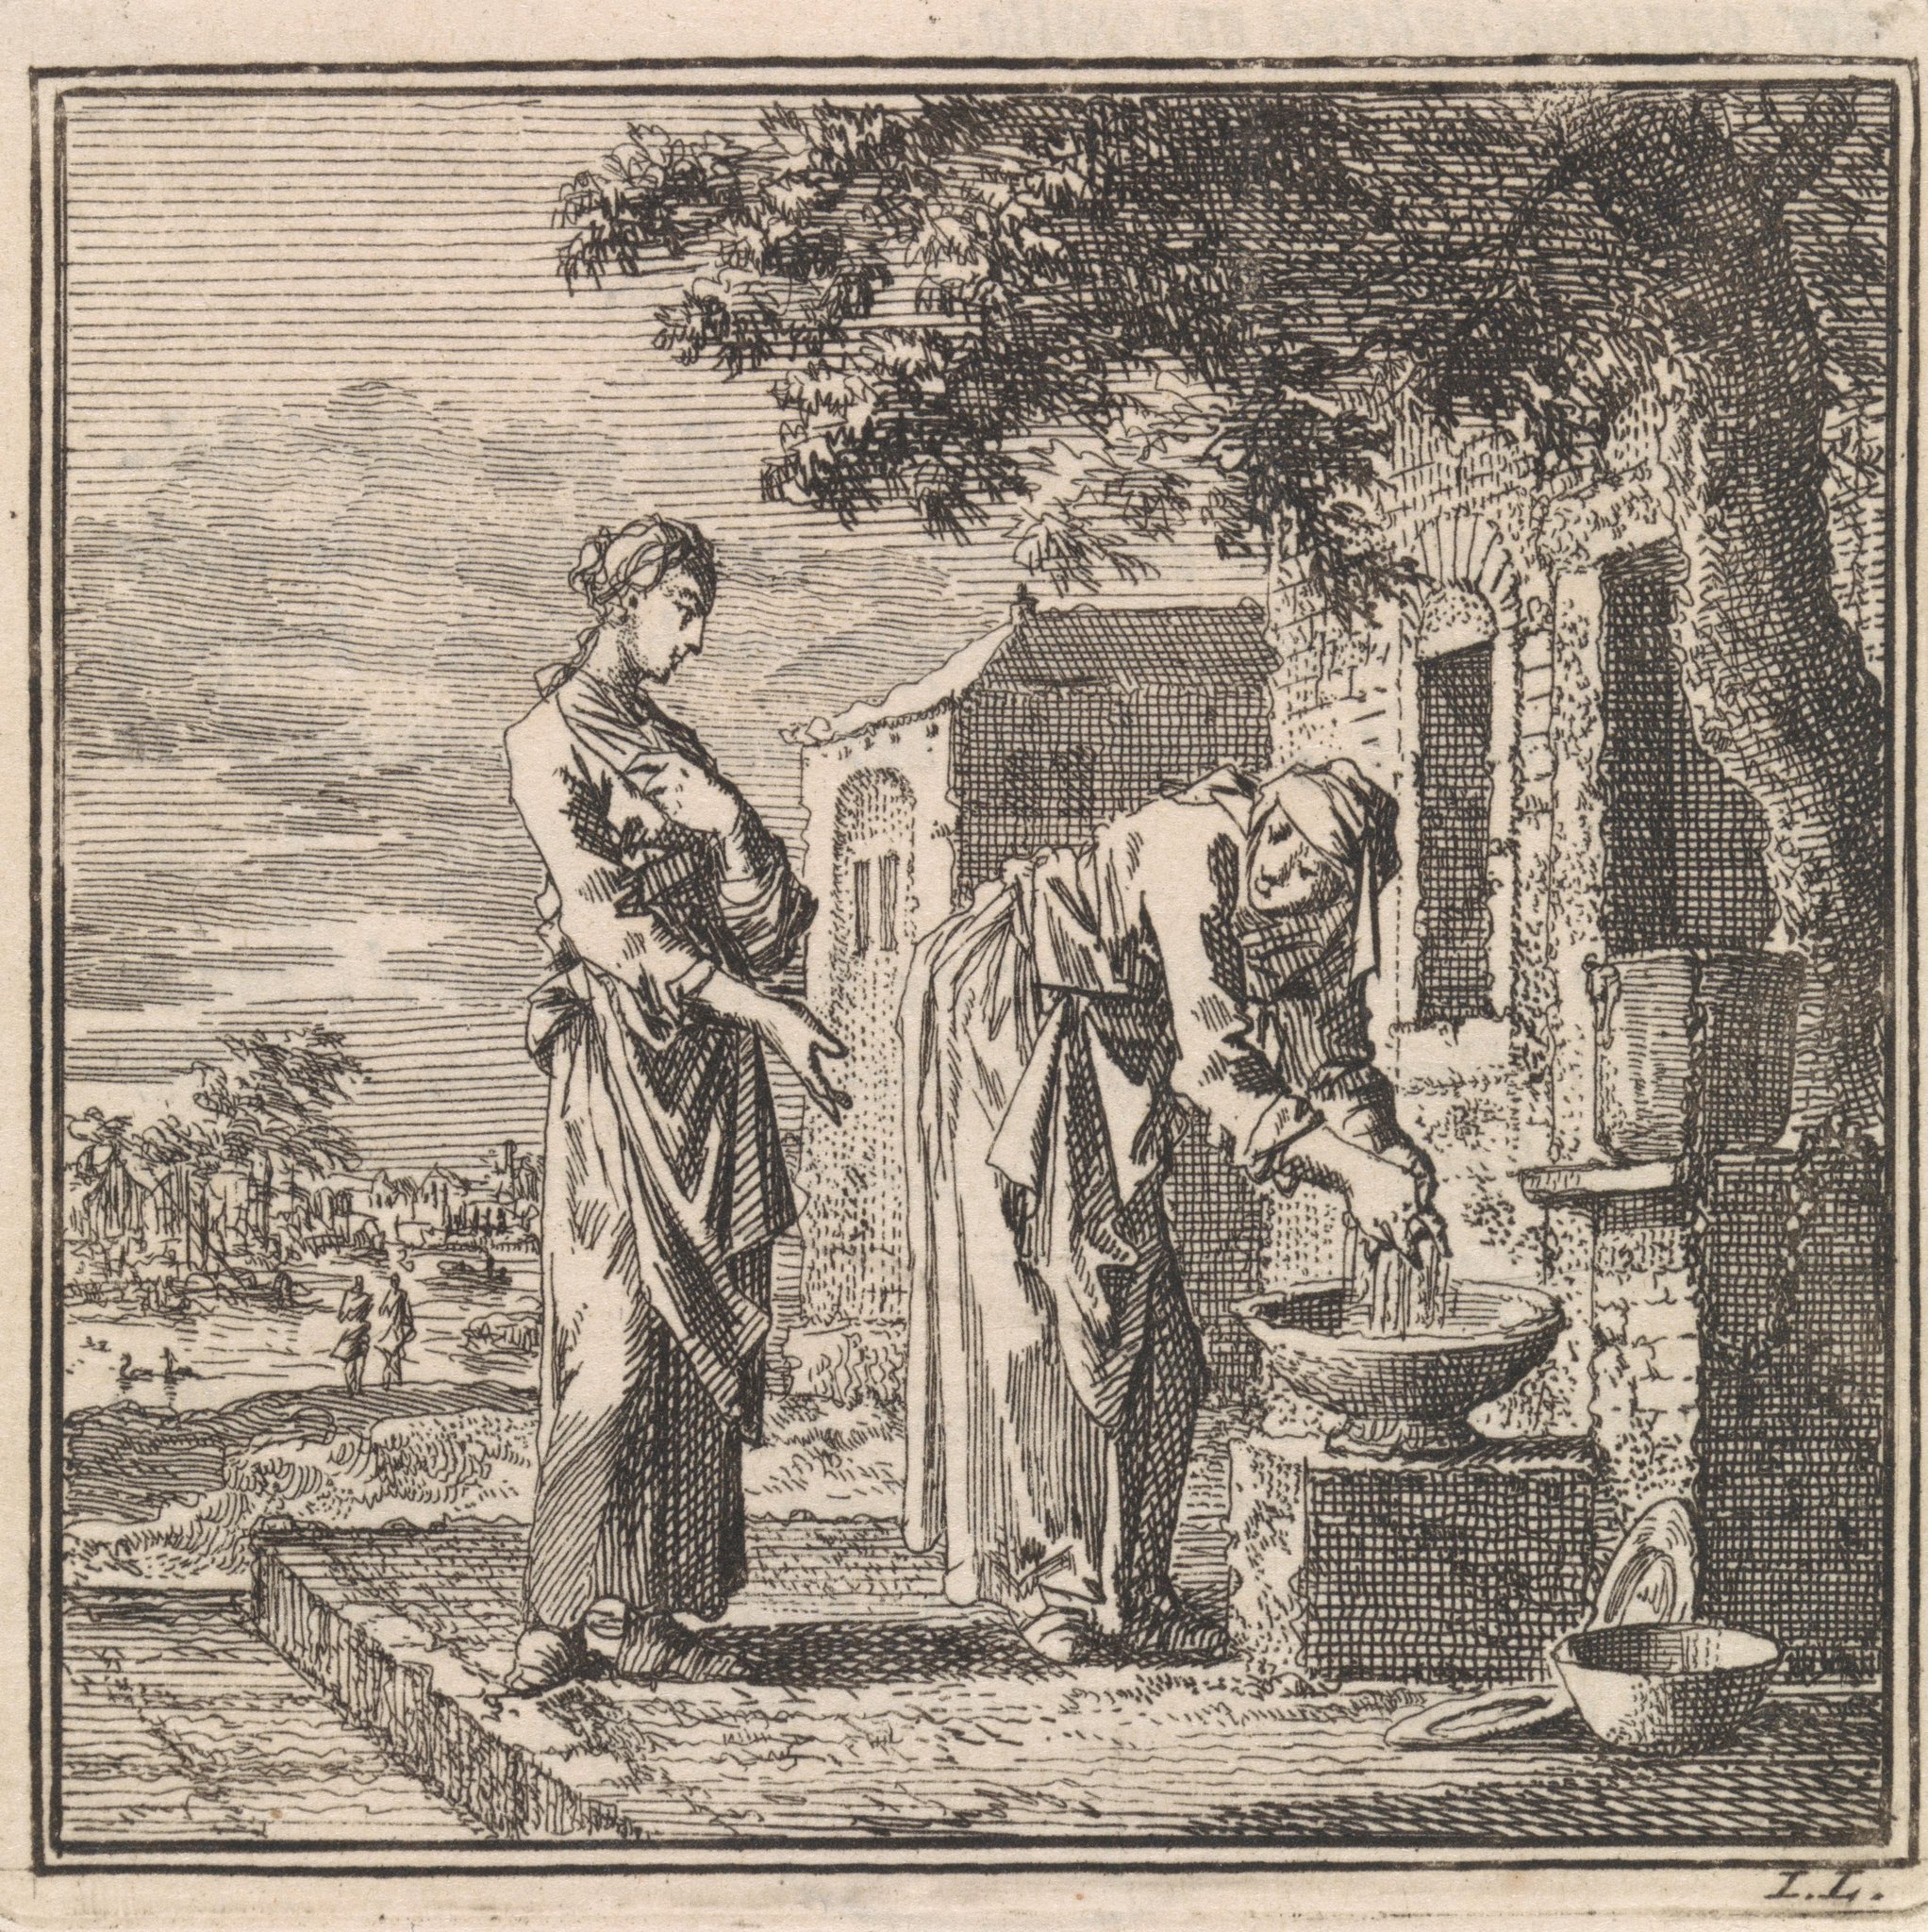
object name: print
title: De eene Hand Wast de ander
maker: jan luyken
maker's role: draughtsman, print maker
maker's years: 1649-1712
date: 1711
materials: paper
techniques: etching, letterpress printing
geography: amsterdam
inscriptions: collector's mark: Lugt 2228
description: Illustratie voor: Luyken, Jan. De Bykorf des Gemoeds. Amsterdam: Pieter Arentsz. II (wed.) en Cornelis van der Sys, 1711, p. 166.